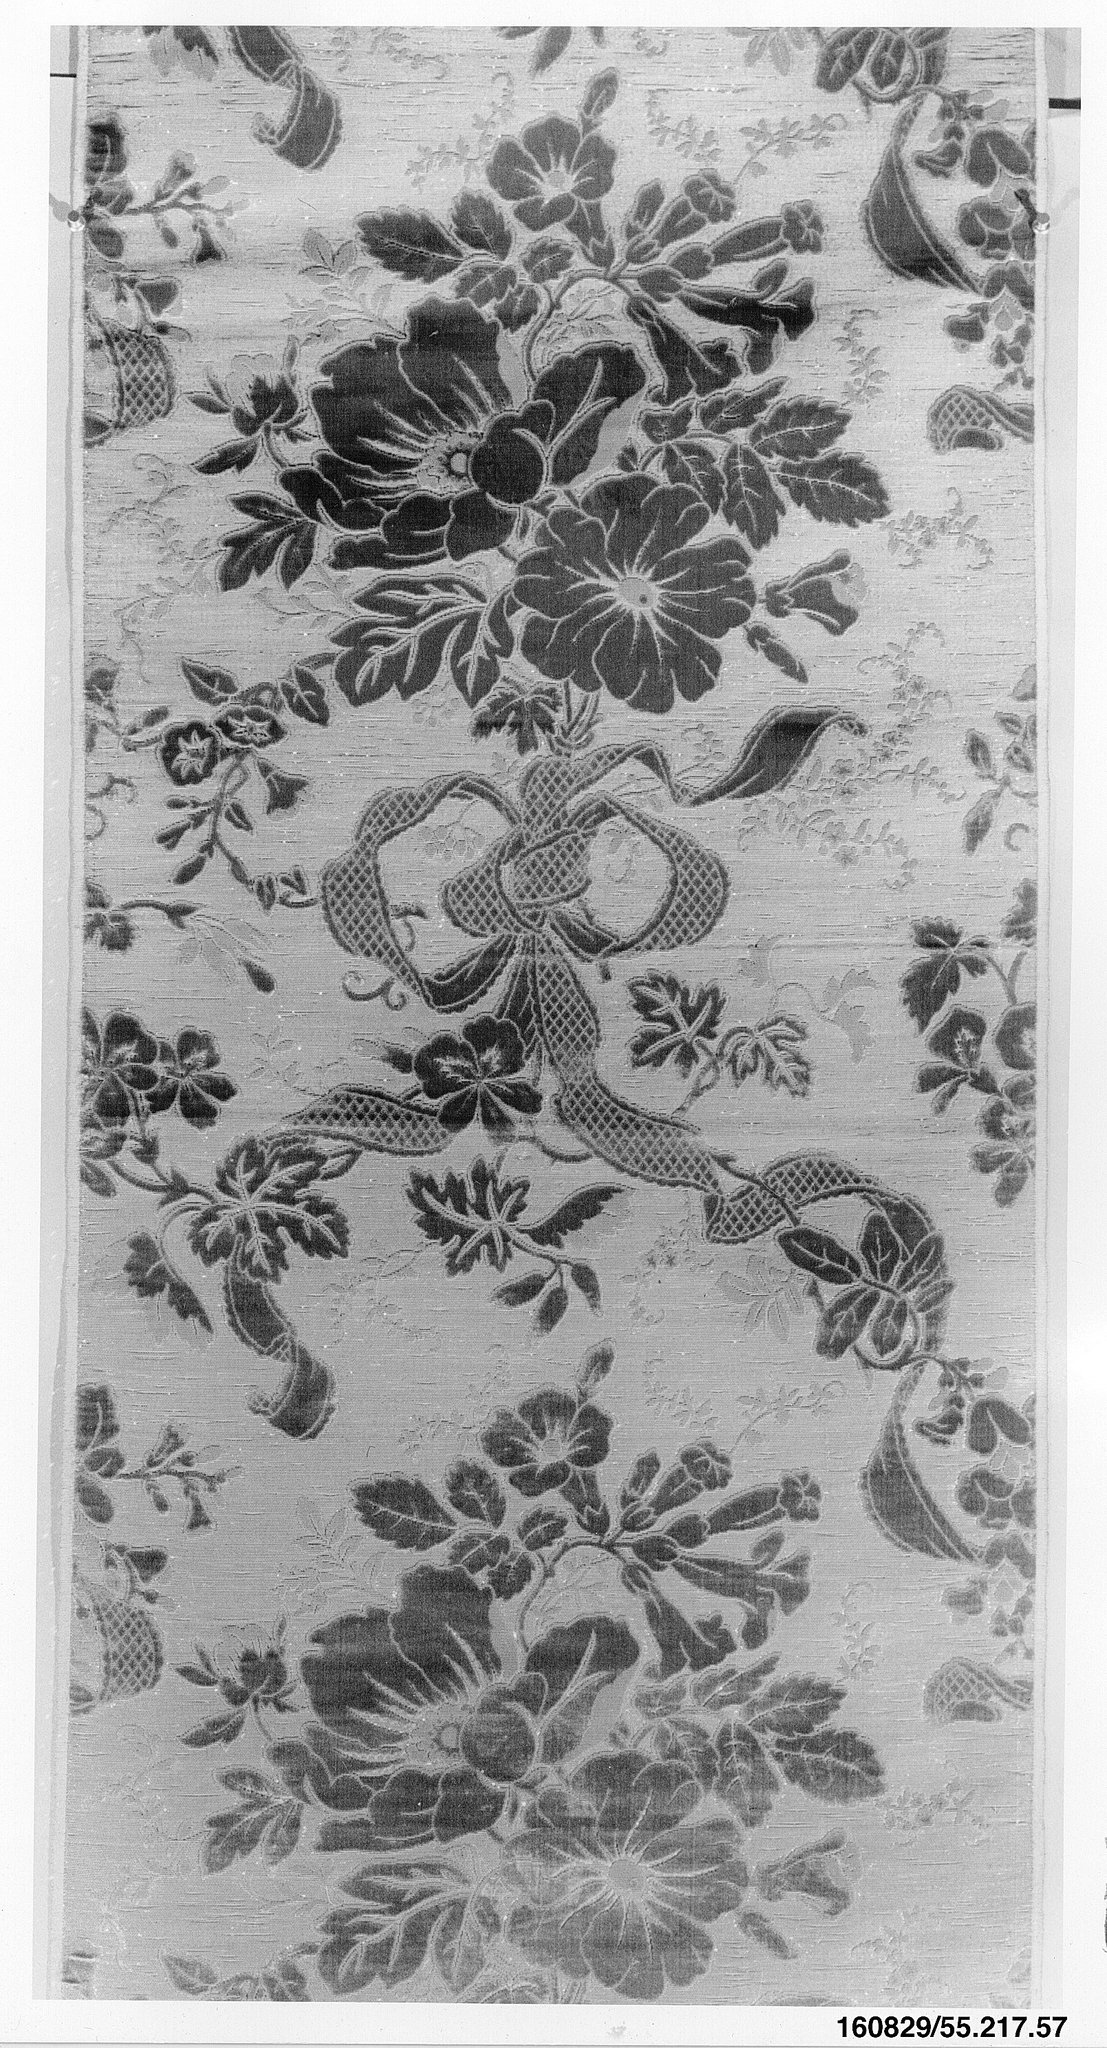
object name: piece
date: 1867-1900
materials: metal thread, silk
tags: flowers,leaves